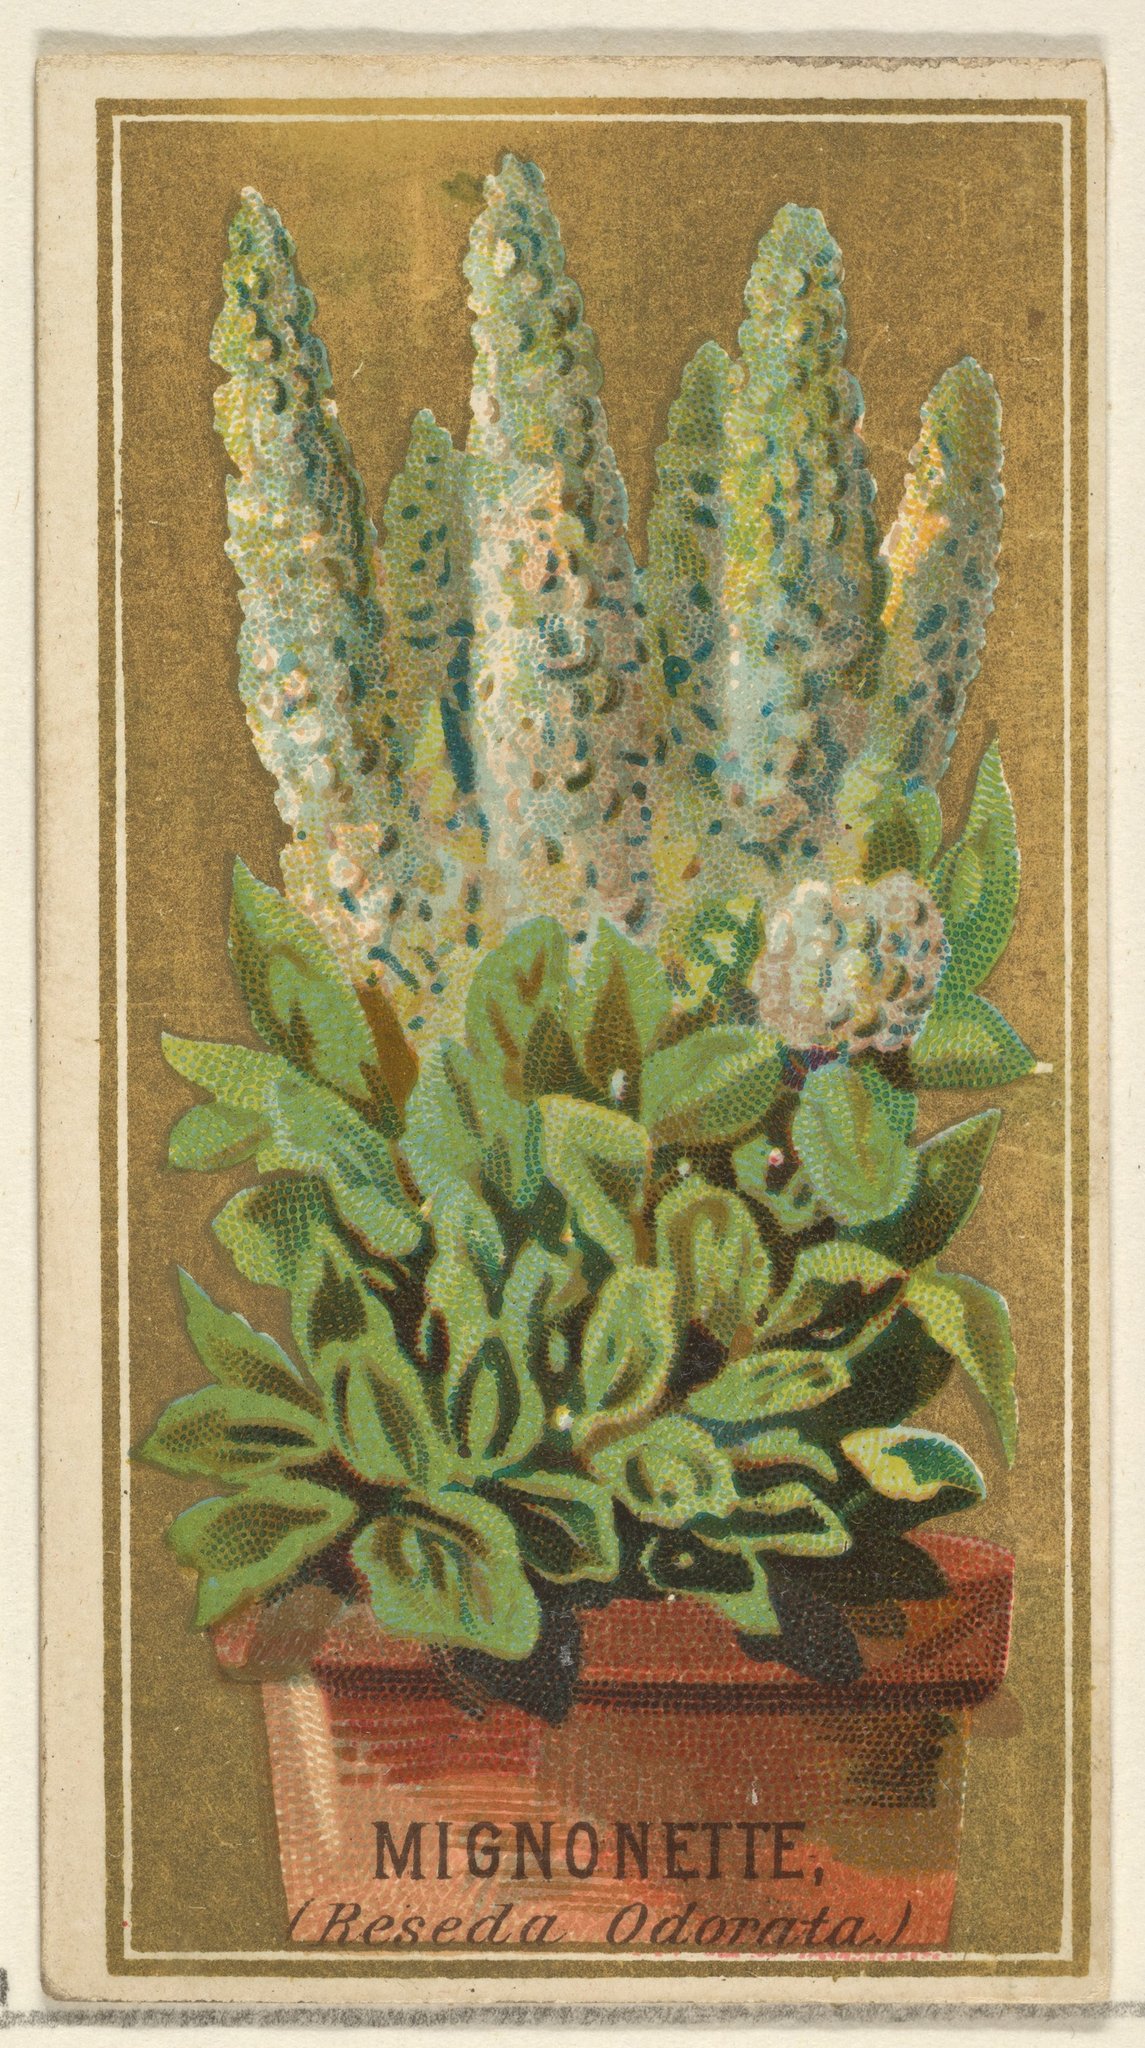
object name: print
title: Mignonette (Reseda Odorata), from the Flowers series for Old Judge Cigarettes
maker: goodwin & company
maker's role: publisher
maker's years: 1850-1950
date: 1890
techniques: color lithograph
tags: flowers,plants